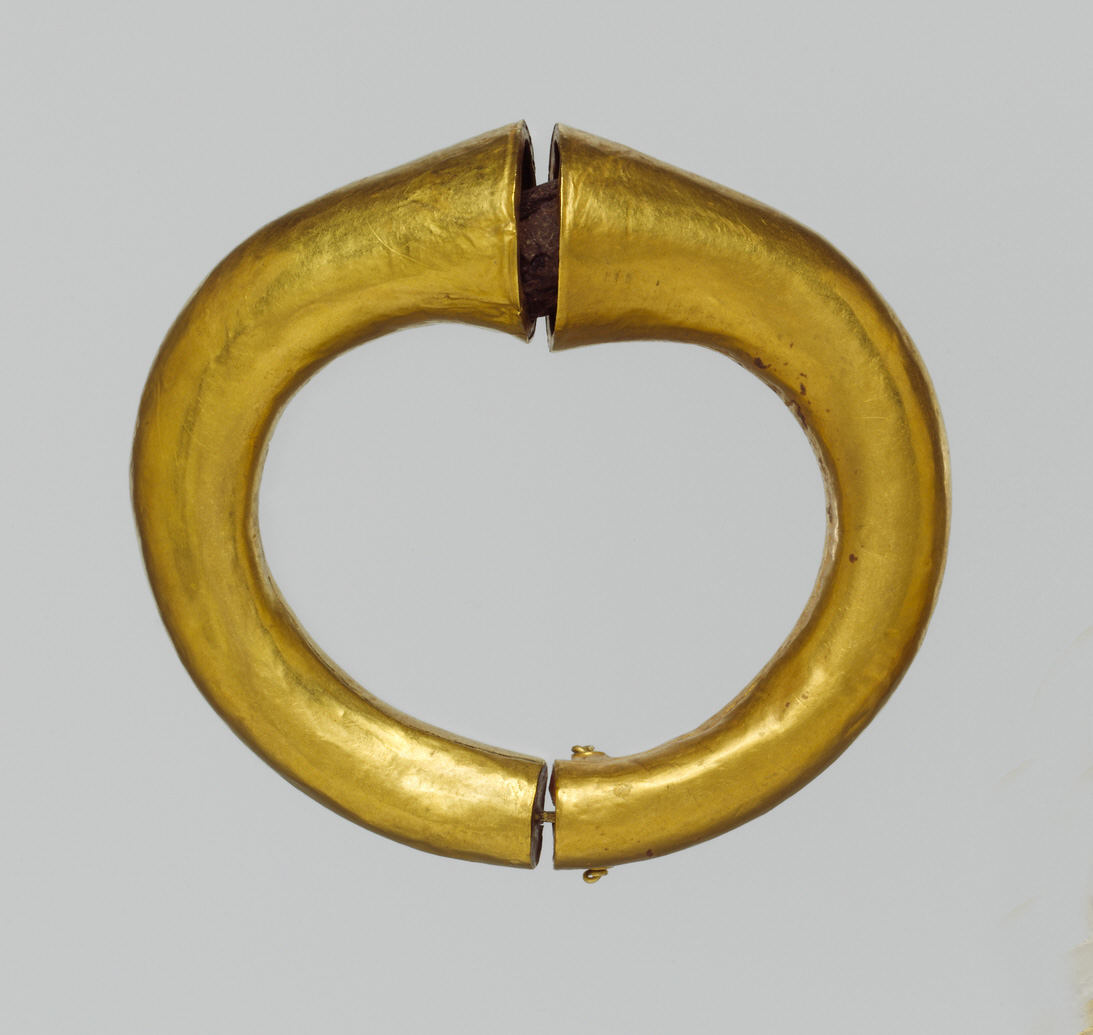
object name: armlet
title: Hinged Armlet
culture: pakistani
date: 1-100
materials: gold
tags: gandhara